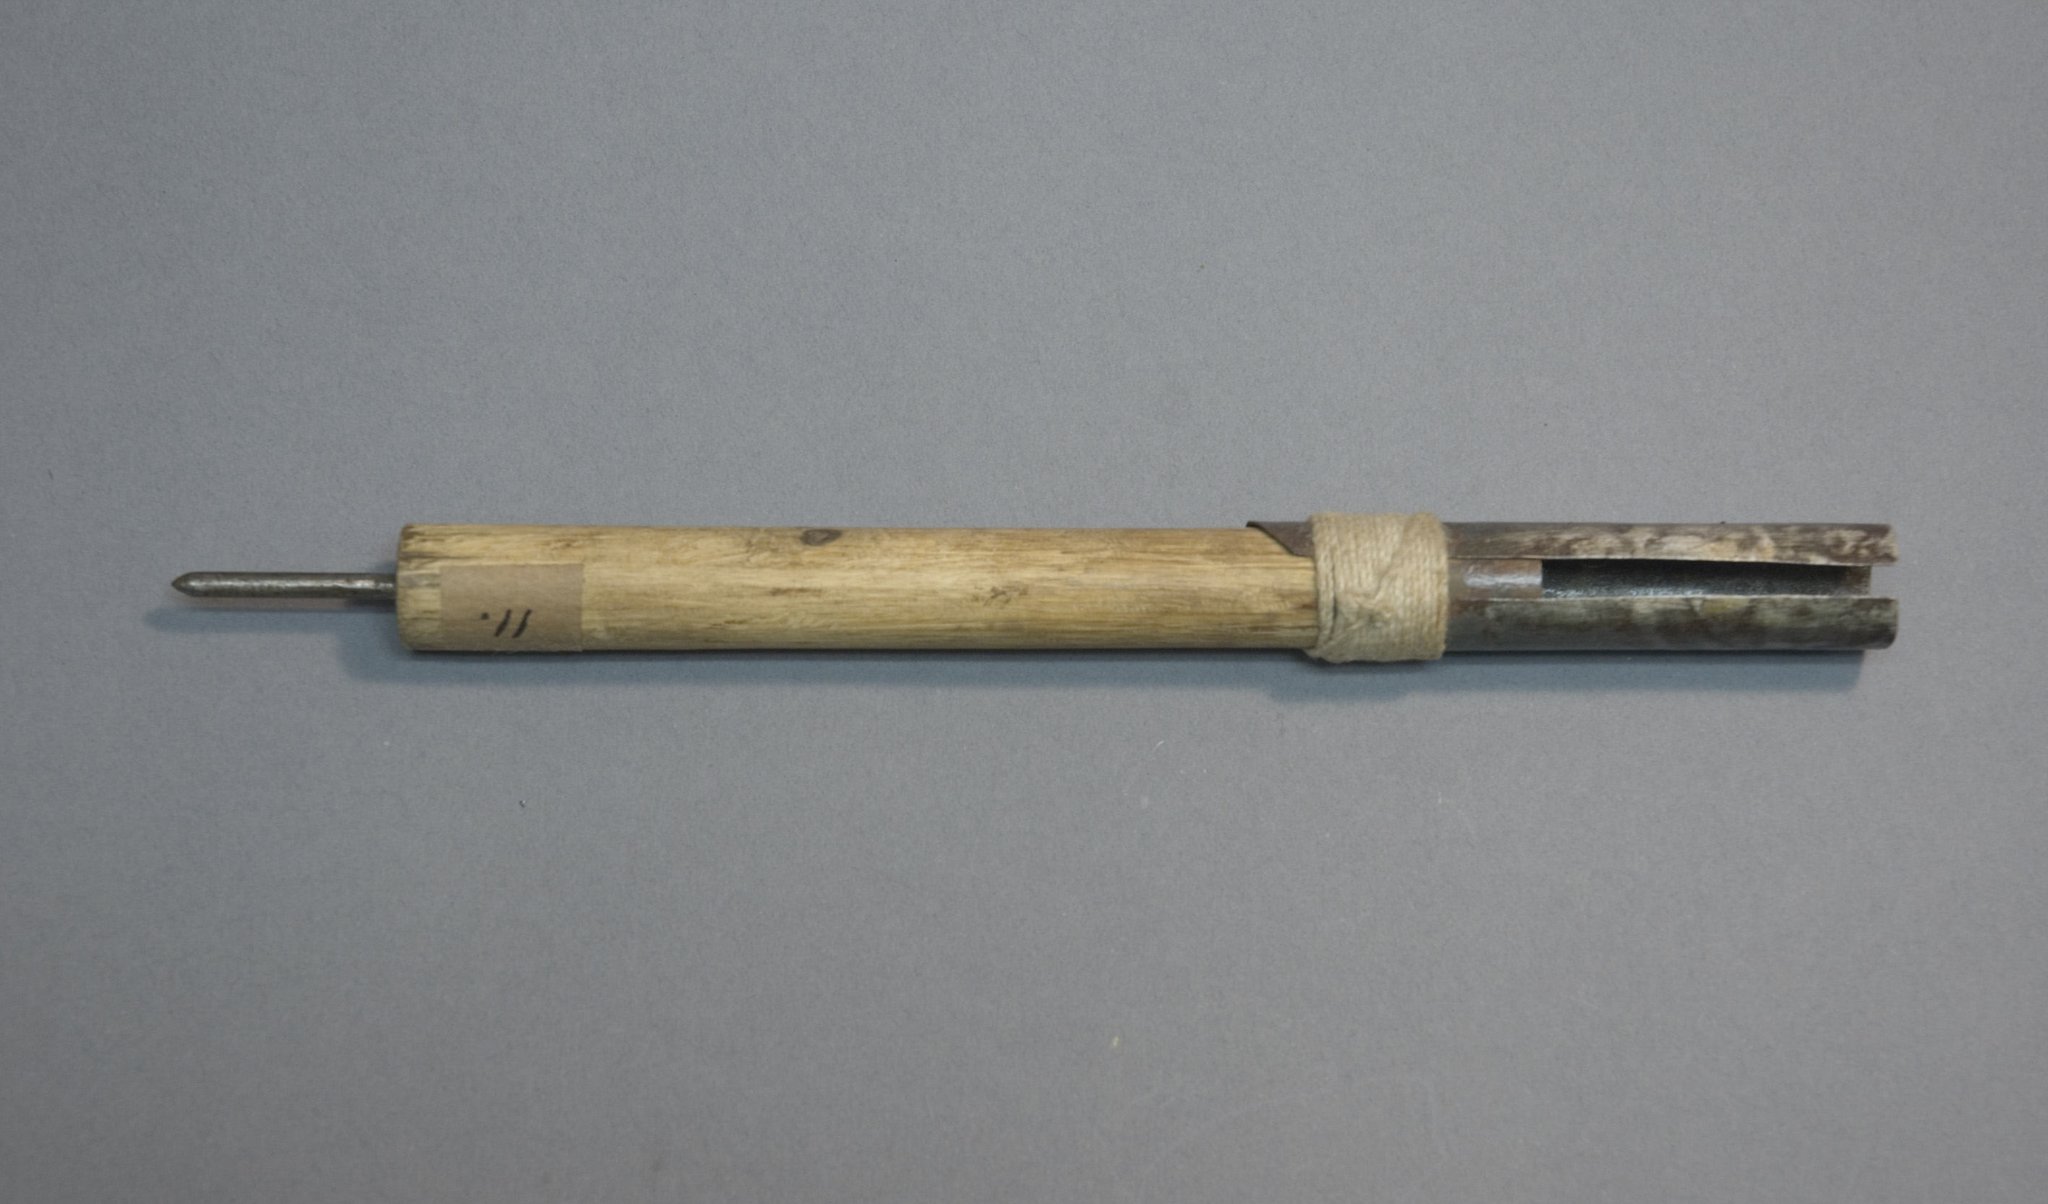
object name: jade carving tool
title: Tubular Bowdrill for Carving Jade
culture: chinese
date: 1901-2000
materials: metal, wood